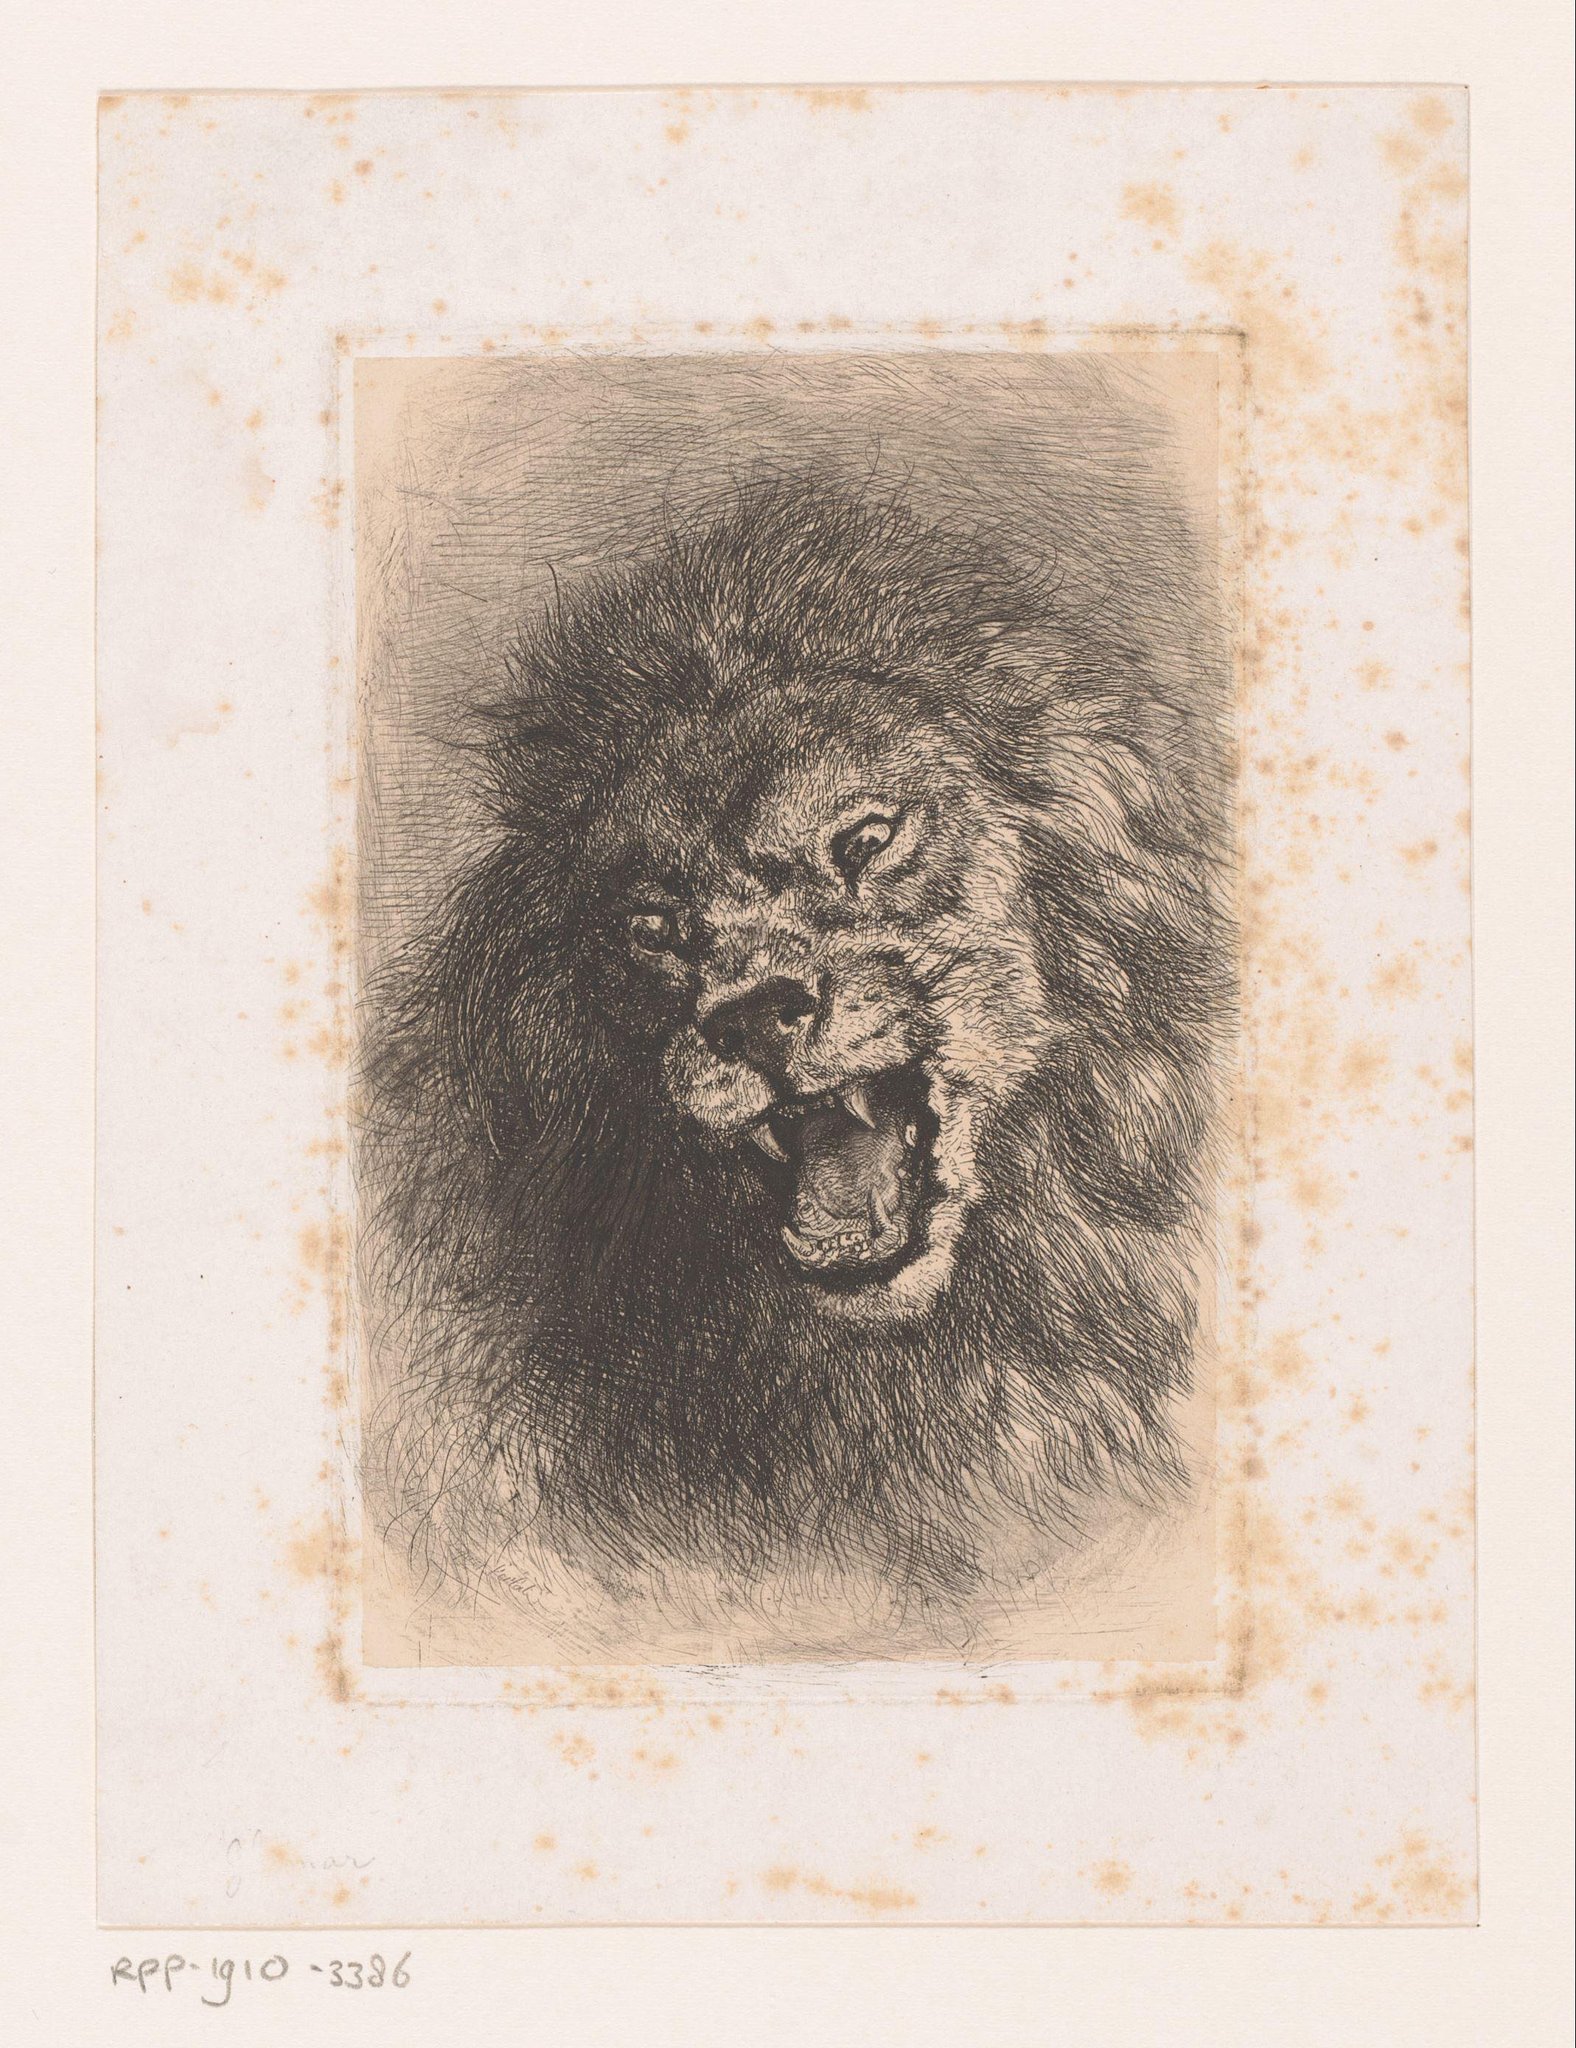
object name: print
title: Leeuwenkop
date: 1829-1873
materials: paper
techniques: etching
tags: beasts of prey, predatory animals: lion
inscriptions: collector's mark: Lugt 2228, collector's mark: Lugt 1485